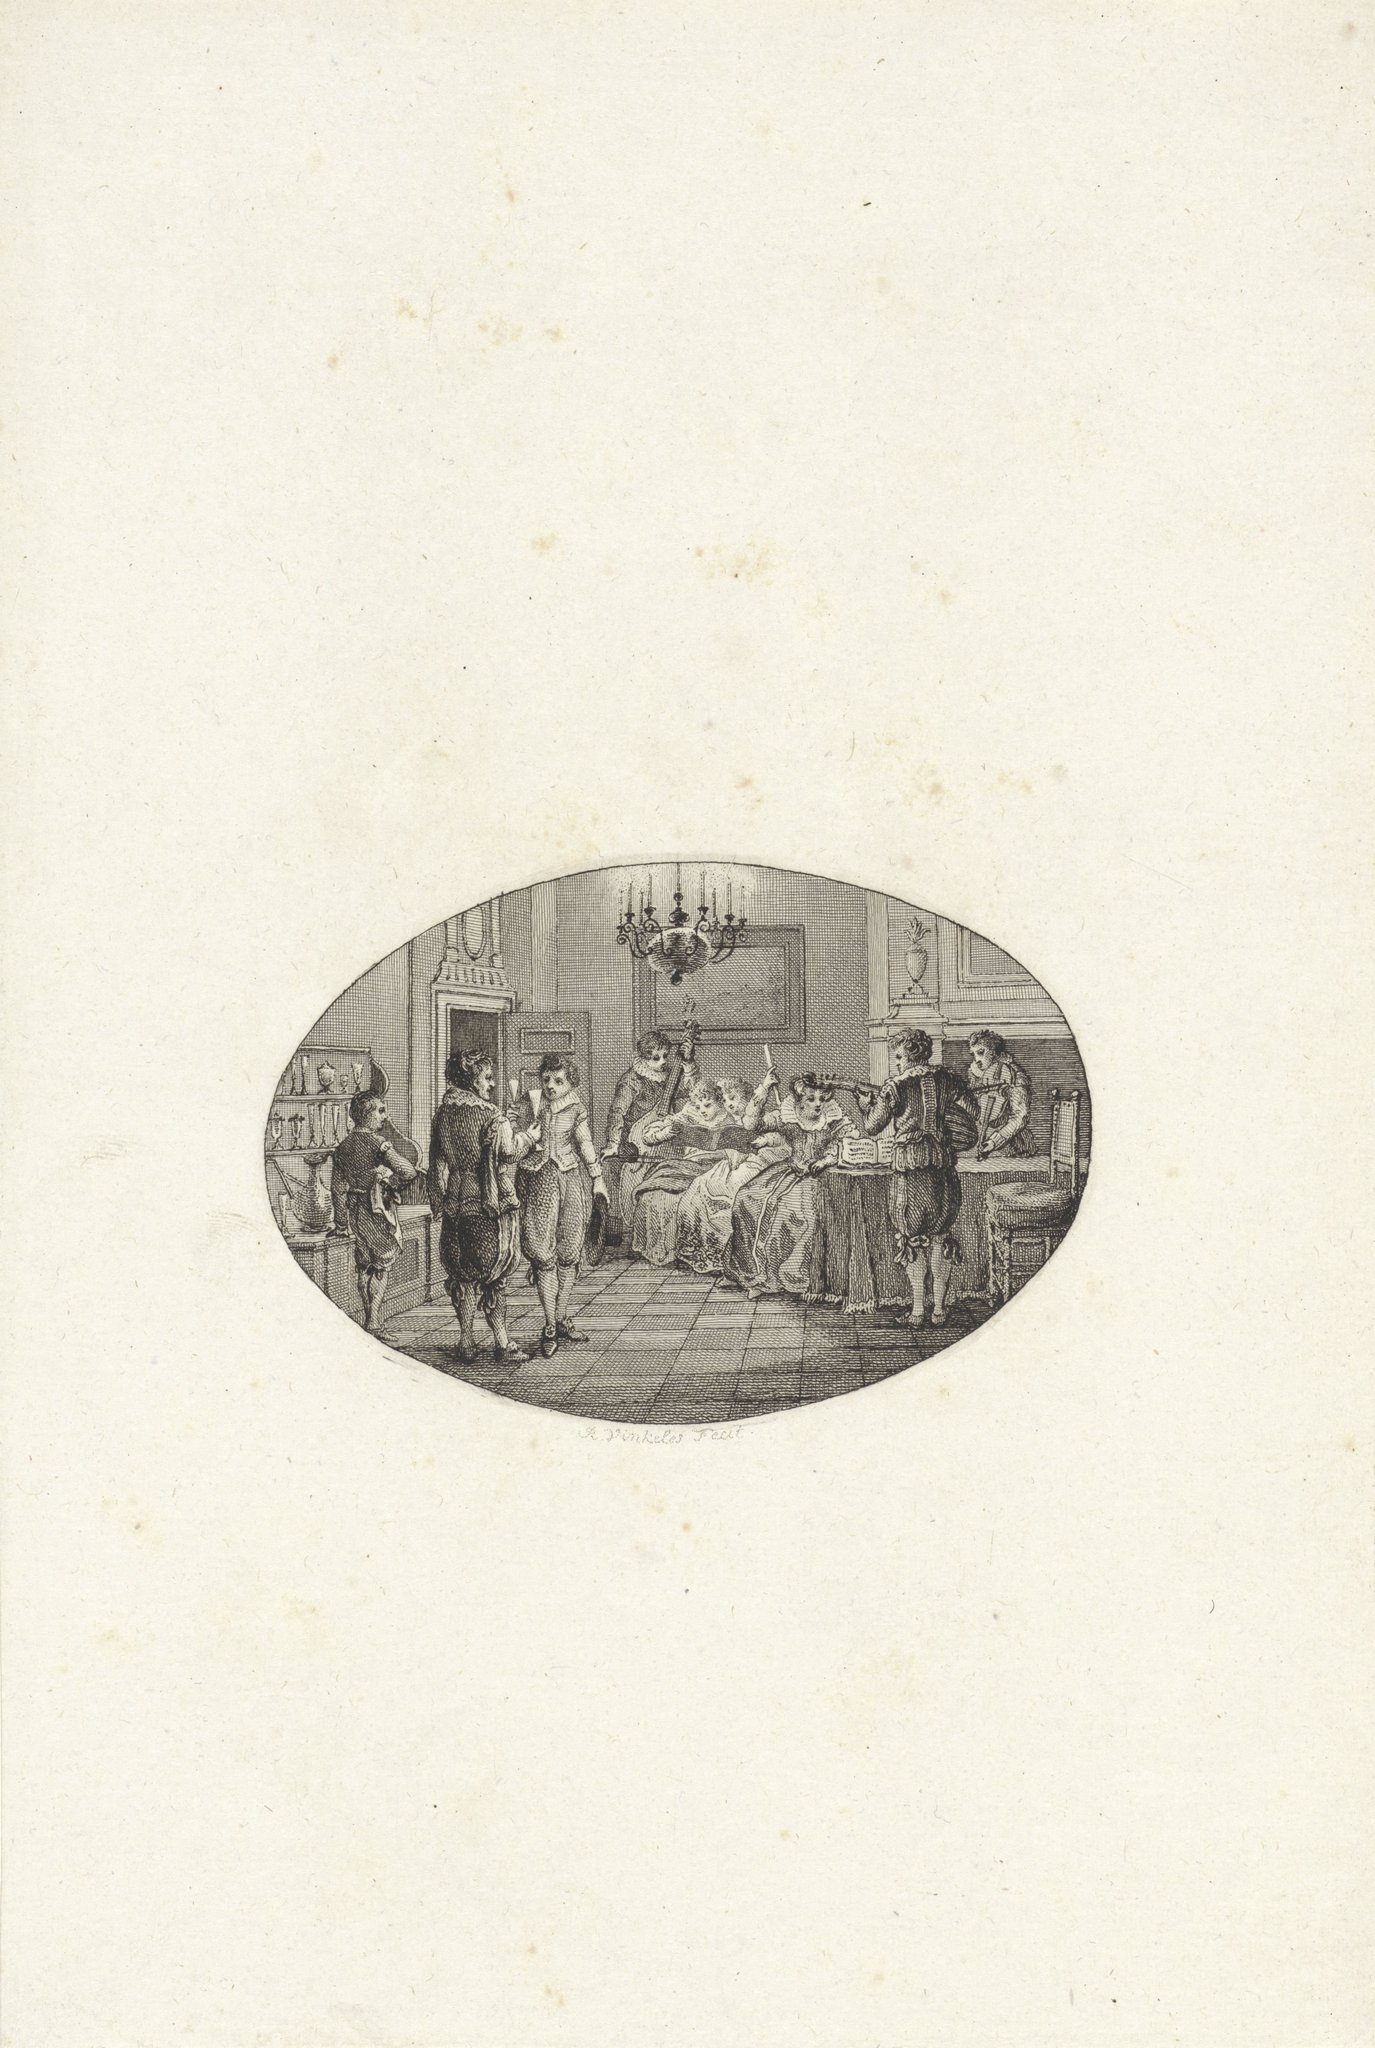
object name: print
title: Titelpagina voor: Adriaan Pietersz. Loosjes,'Het Leven van Maurits Lijnslager', 1808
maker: reinier vinkeles (i)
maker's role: draughtsman, print maker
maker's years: 1741-1816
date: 1751-1816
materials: paper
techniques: engraving, etching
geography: amsterdam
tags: instrumental and vocal music together, banquet of elegant company (+ toast at meal, banquet)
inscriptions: collector's mark: Lugt 2228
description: Proefdruk van titelpagina voor: Loosjes, Adriaan Pietersz. Het leven van Maurits Lijnslager : eene Hollandsche familiegeschiedenis uit de zeventiende eeuw. Haarlem: Adriaan Pietersz. Loosjes, 1808.